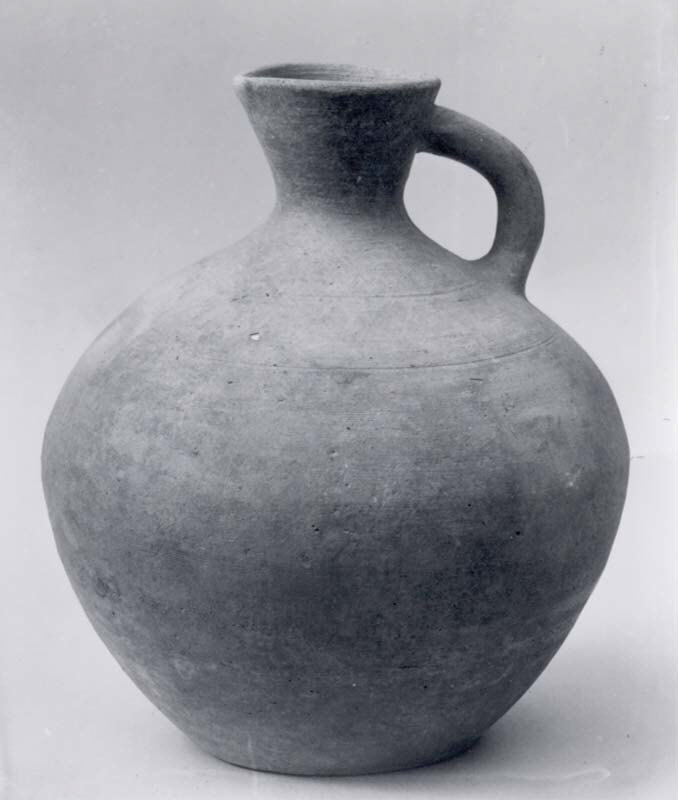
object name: jug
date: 2000-1001 BCE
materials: ceramic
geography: iran